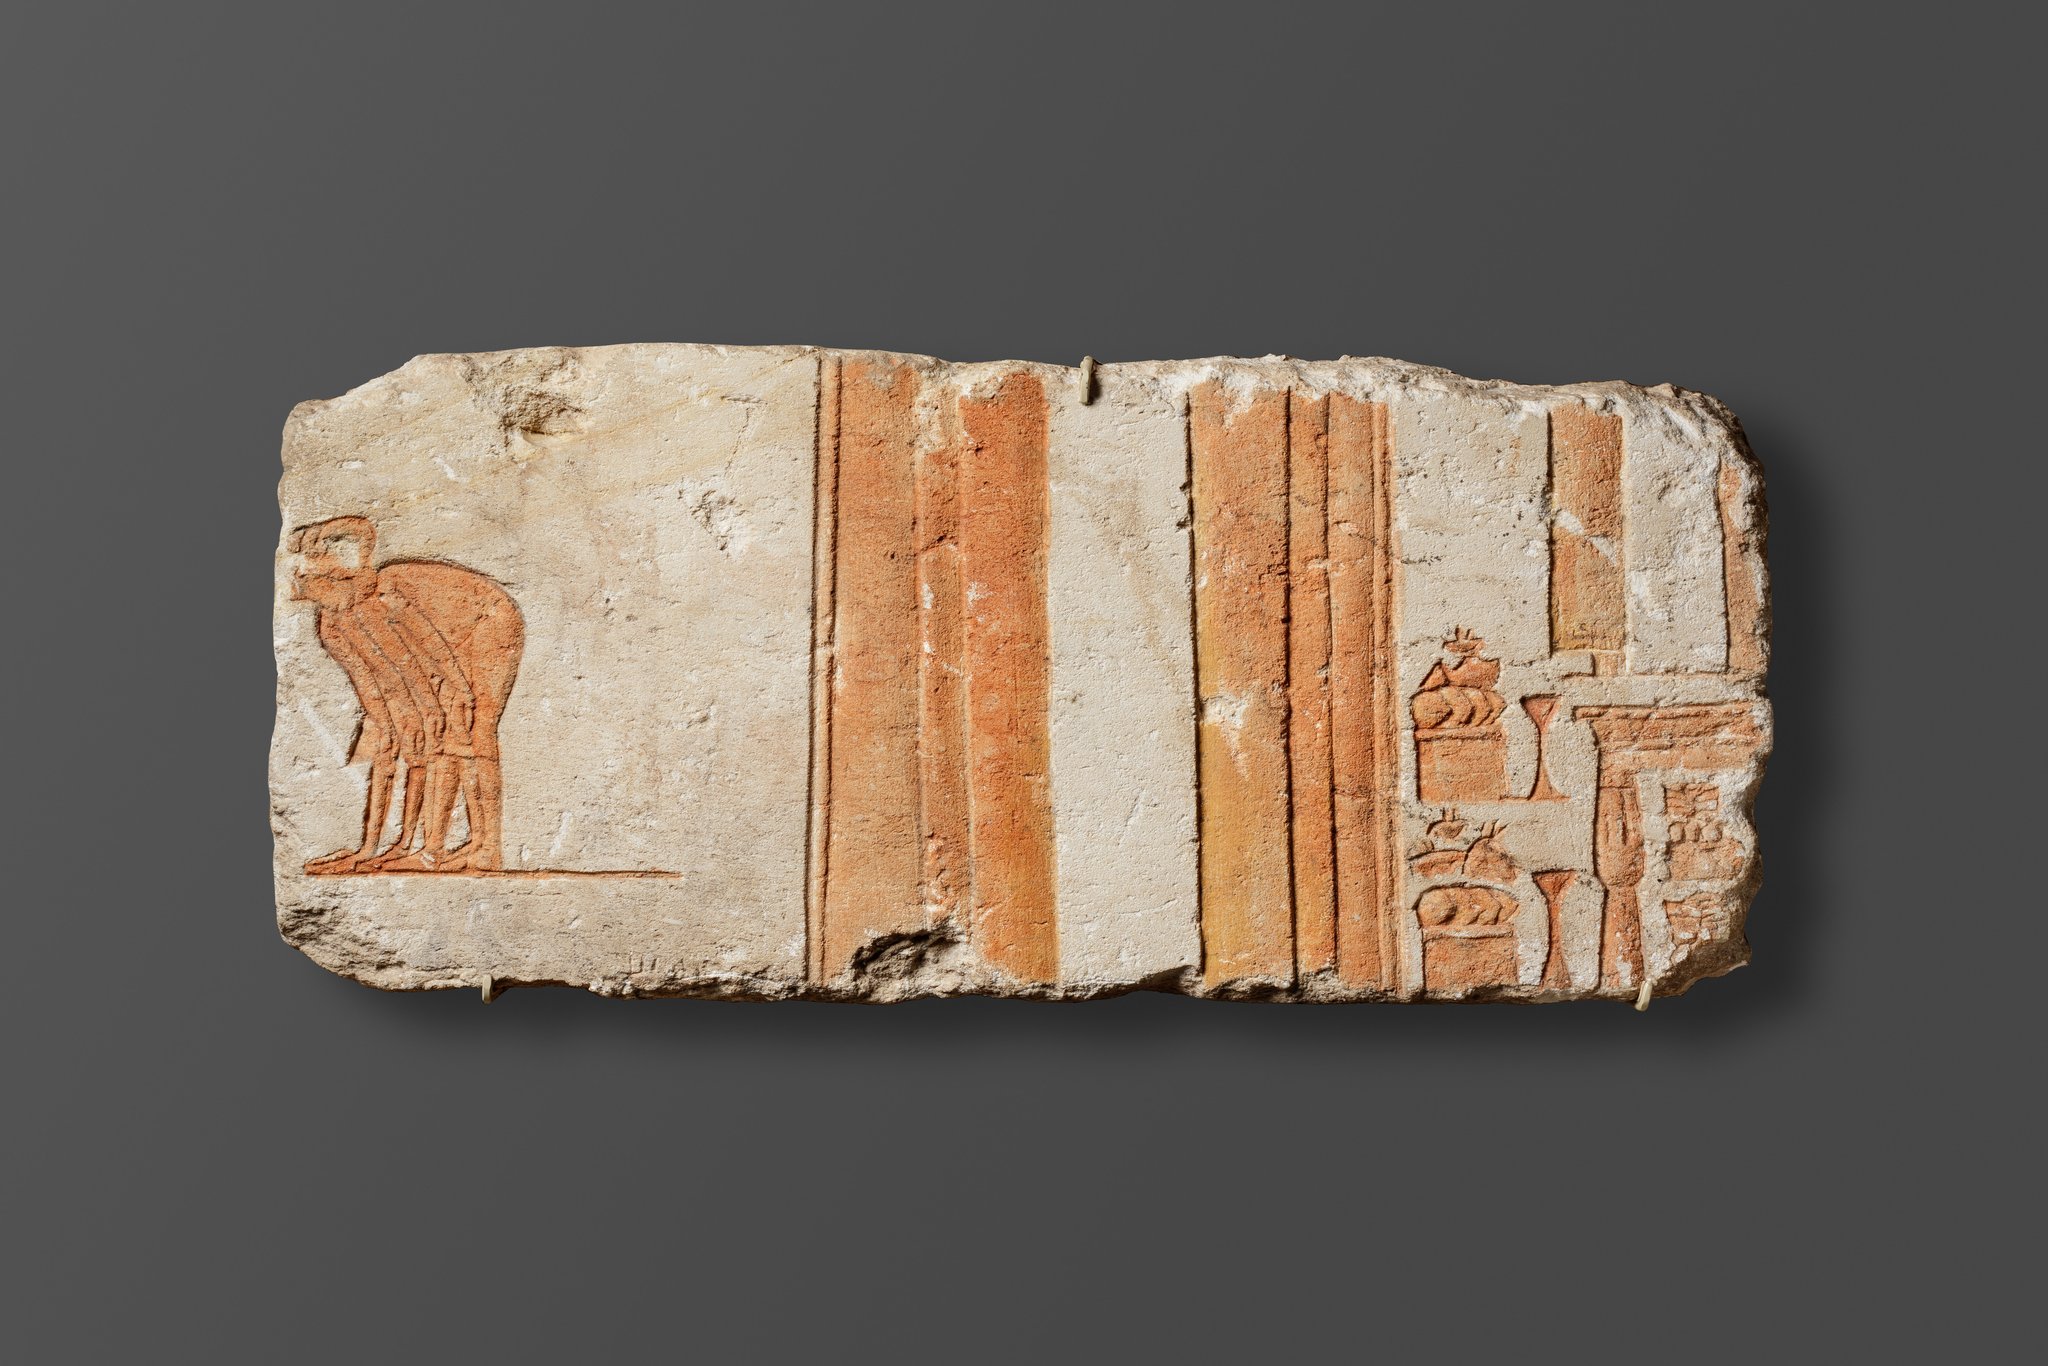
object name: talatat, official before a temple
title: Relief with officials before a temple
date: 1353-1336 BCE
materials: limestone, paint